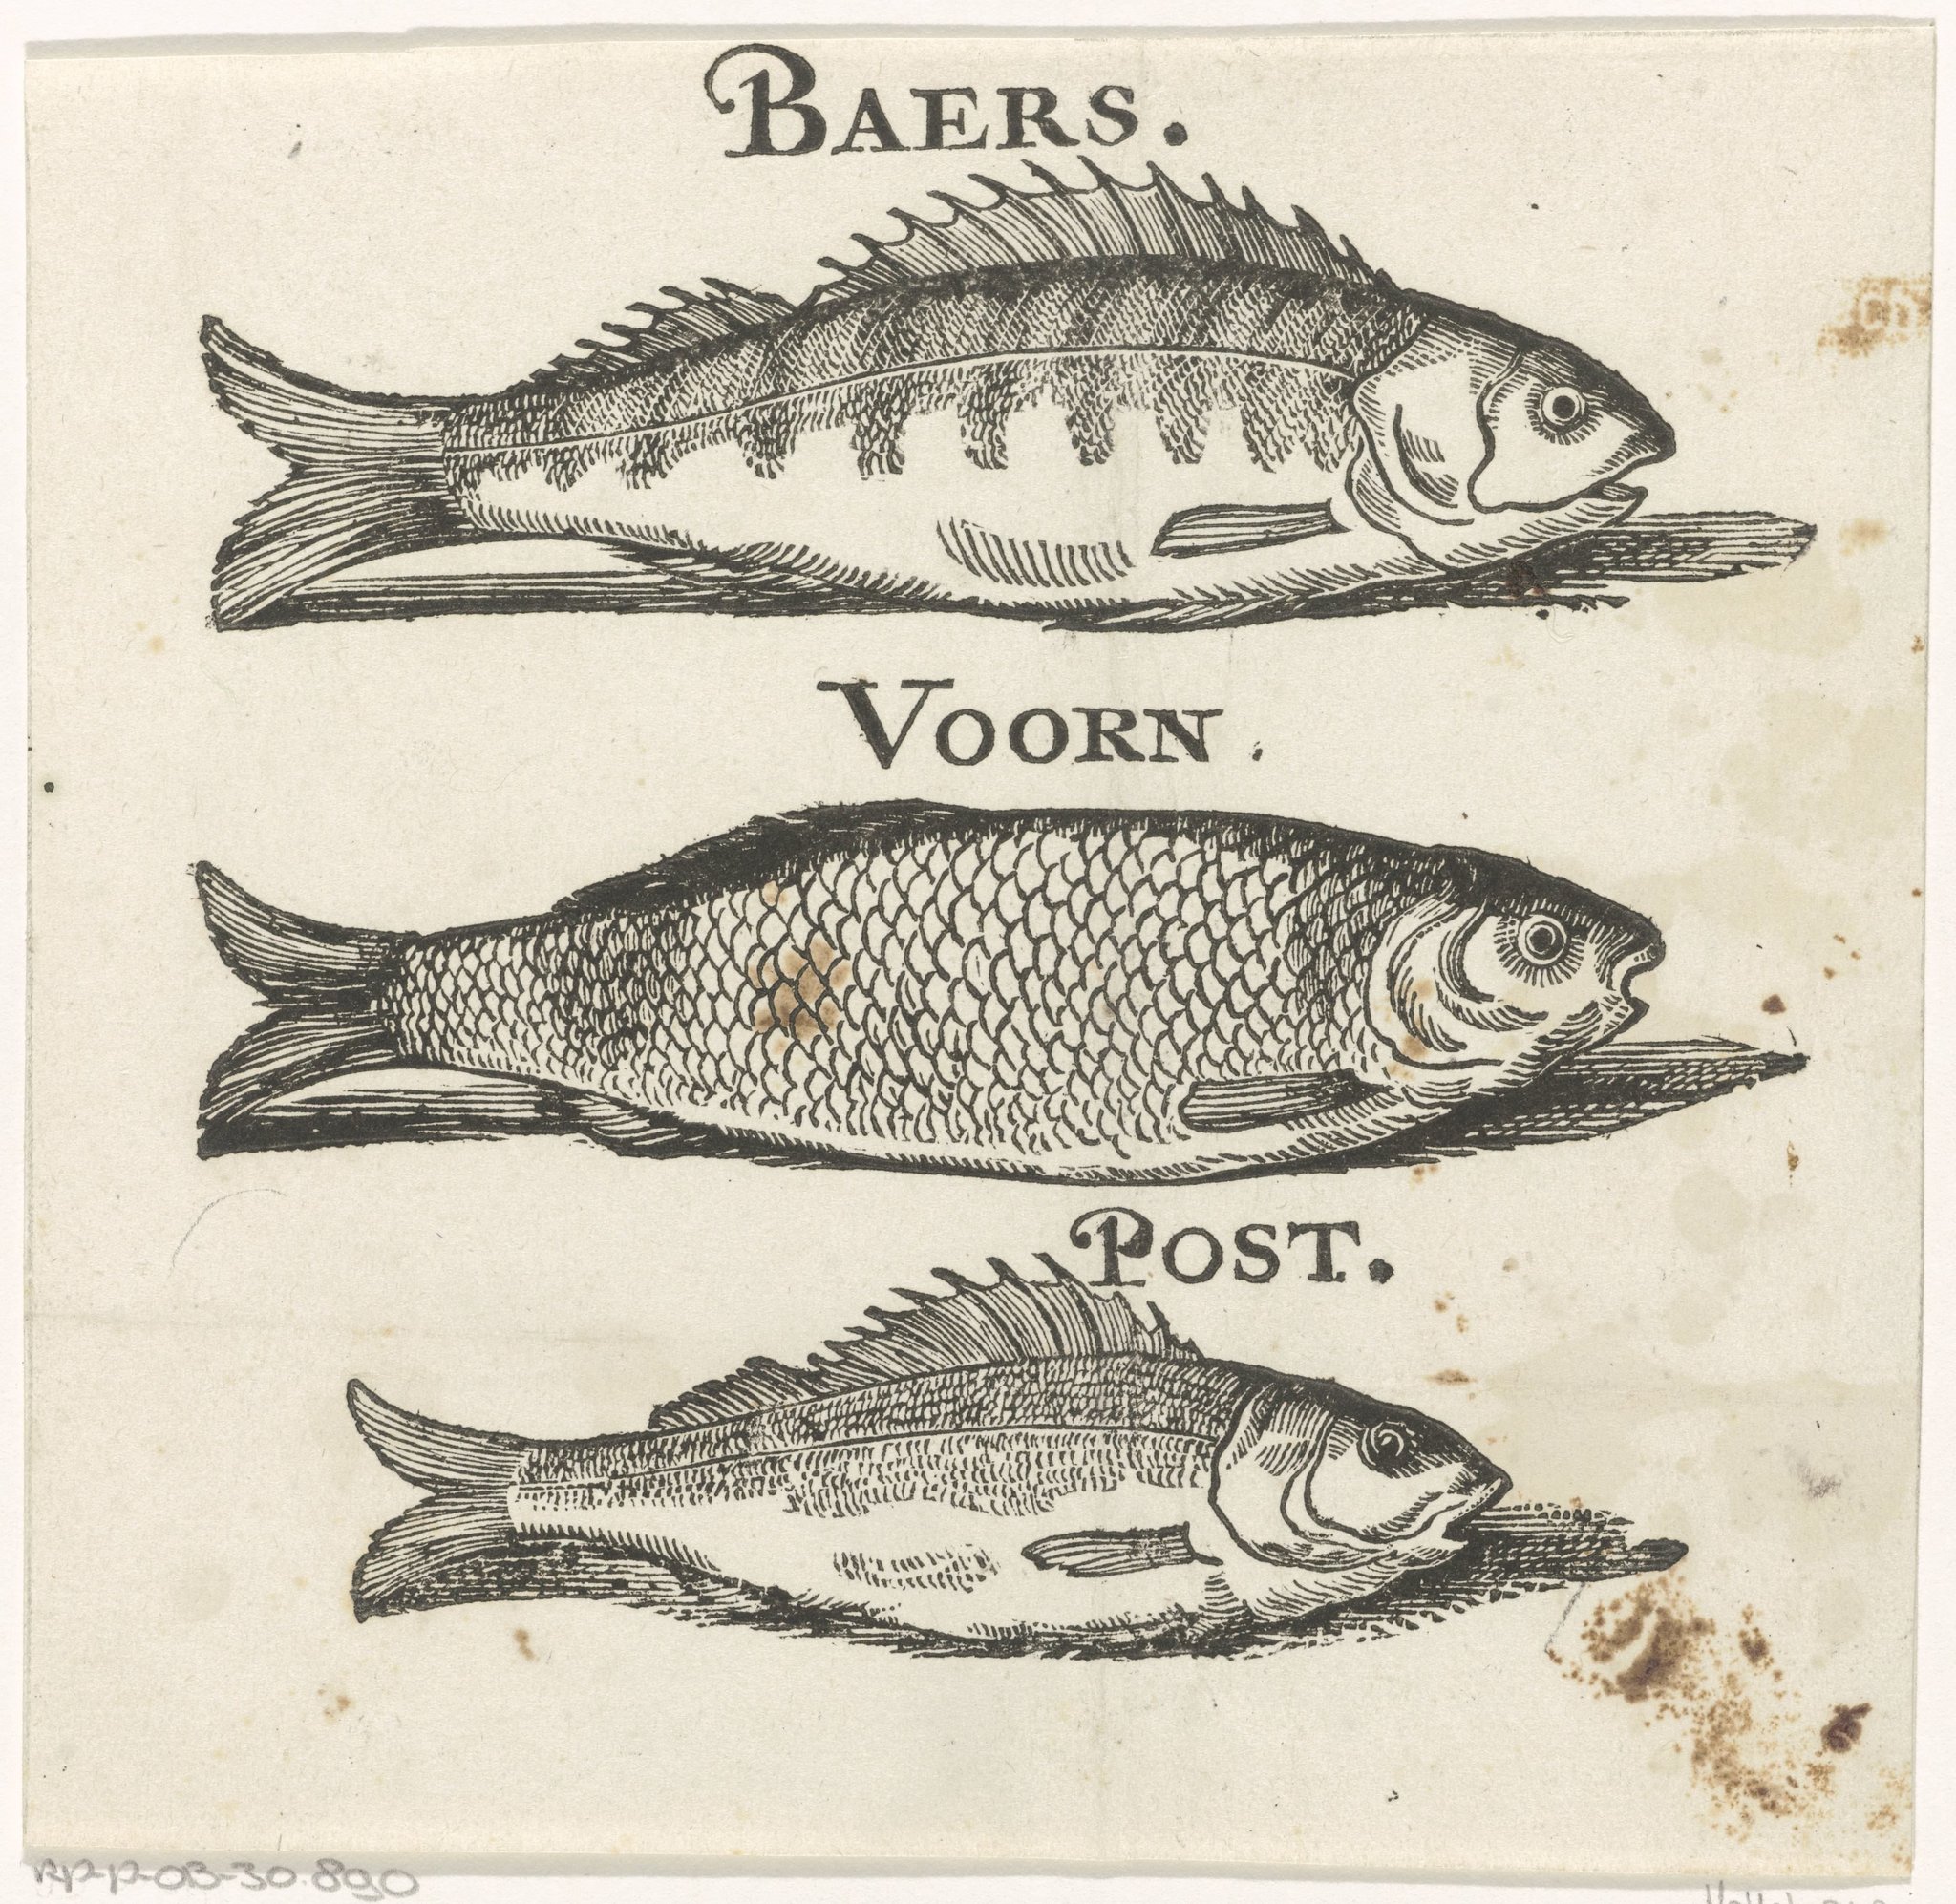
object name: print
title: Baars, een voorn en een pos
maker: isaac vincentsz. van der vinne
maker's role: draughtsman, print maker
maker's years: 1665-1740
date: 1681-1740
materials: paper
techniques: woodcut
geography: haarlem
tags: bony fishes: perch, bony fishes: roach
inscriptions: collector's mark: Lugt 240